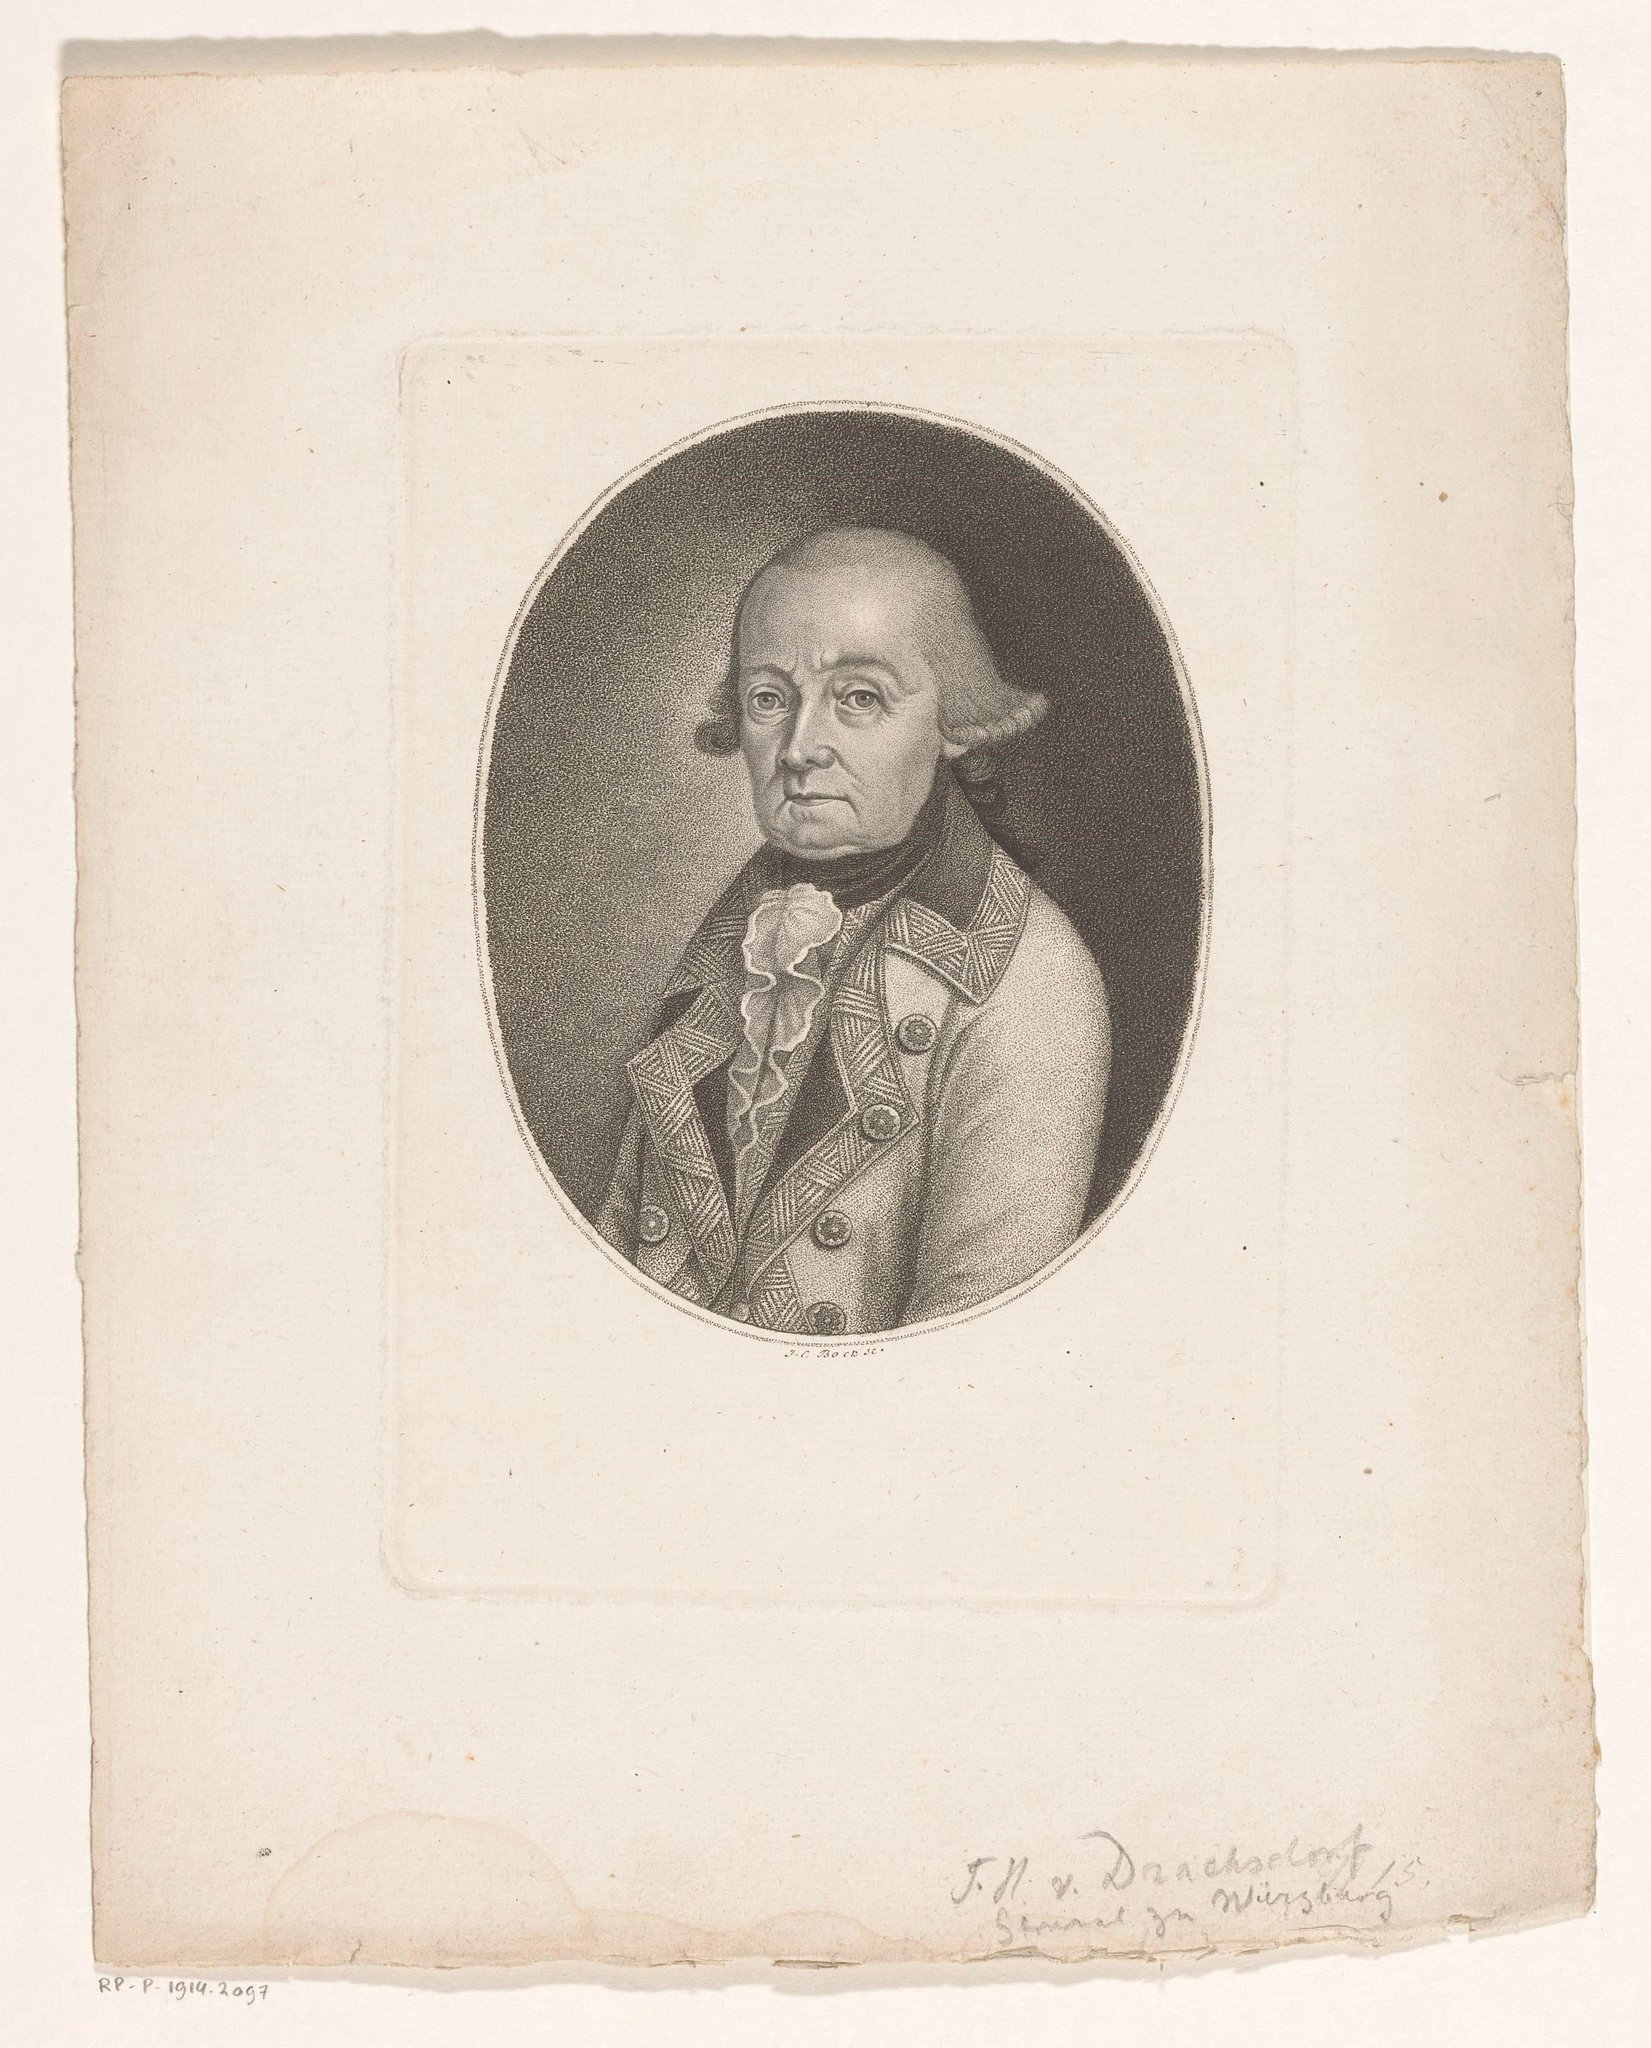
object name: print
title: Portret van Karl von Drachsdorf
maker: johann carl bock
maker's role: print maker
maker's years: 1757-1843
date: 1767-1843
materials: paper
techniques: etching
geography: nuremberg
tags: historical persons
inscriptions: collector's mark: Lugt 2228